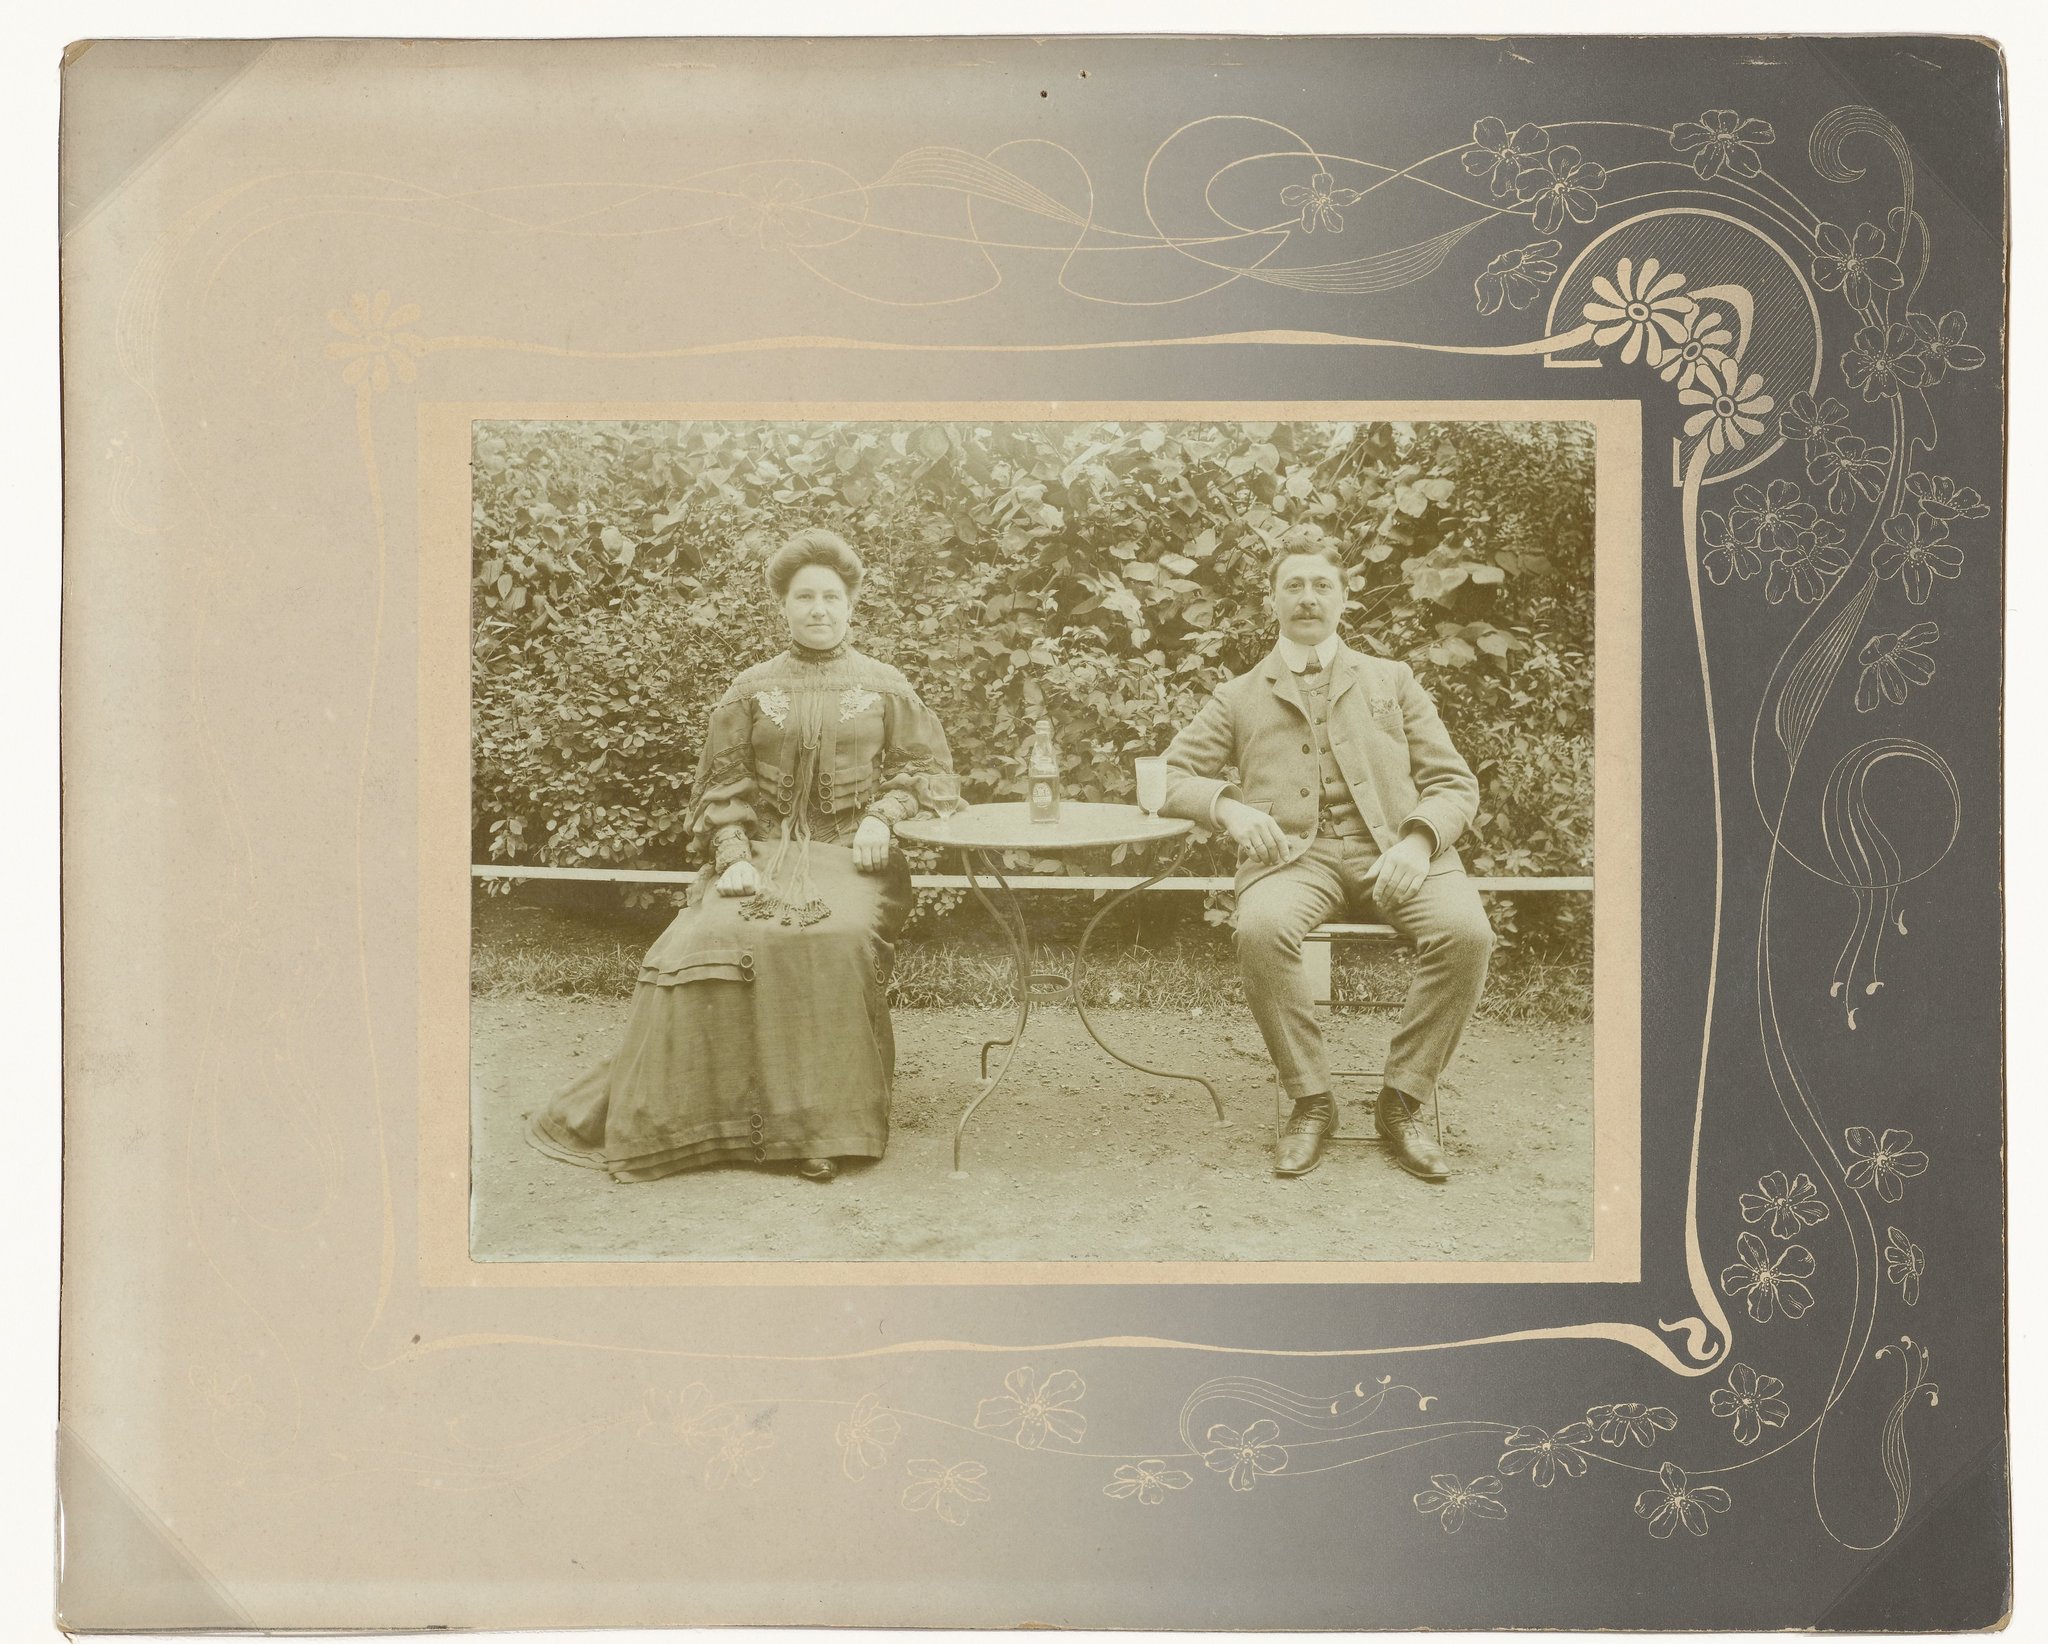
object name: photograph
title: Portret van een zittend echtpaar in een tuin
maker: j.h. jacobs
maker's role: fotograaf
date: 1890-1910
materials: paper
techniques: gelatin silver print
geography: amsterdam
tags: marriage, married couple, 'matrimonium', netherlands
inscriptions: signature: ‘J. H. Jacobs, Amateurfotograaf Joden Breestraat 75, 1e etage Amsterdam’